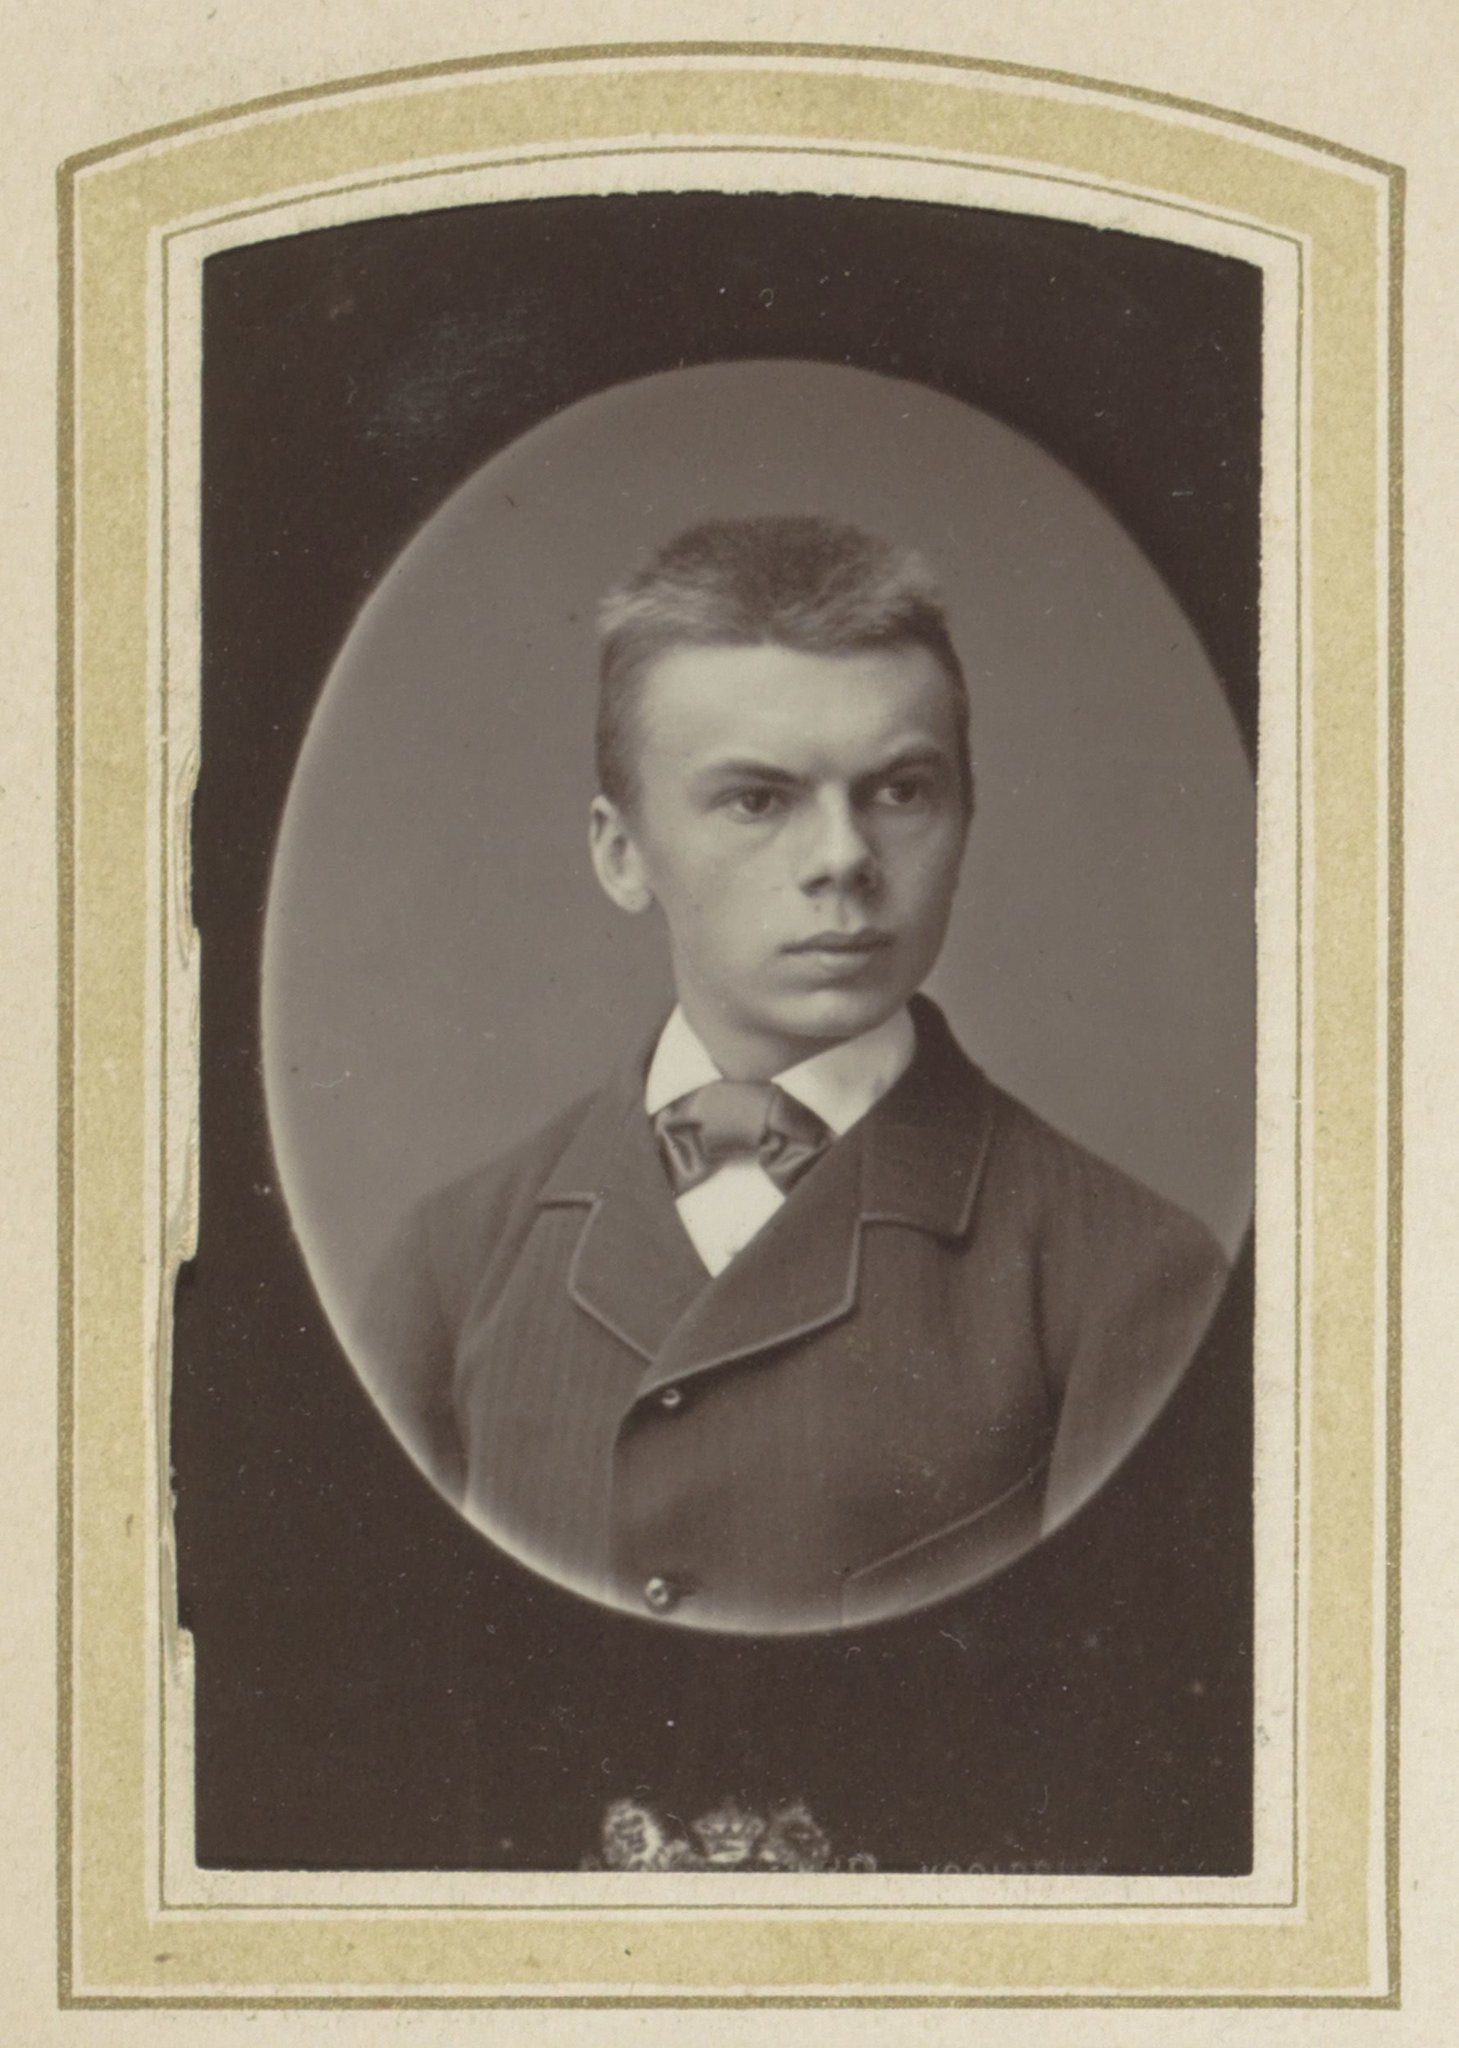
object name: carte de visite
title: Portret van een jongeman met een jas en een das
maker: albert greiner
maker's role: fotograaf, fotostudio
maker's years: 1833-1890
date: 1882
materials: cardboard, paper, photographic support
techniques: carbon print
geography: amsterdam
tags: historical persons, neck-gear ~ clothing, clothing for the upper part of the body, hairdress, amsterdam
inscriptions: address: ‘Amsterdam’, address: ‘Nieuwendijk L. 89 Amsterdam’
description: Onderdeel van Fotoalbum van een Nederlandse familie met 168 cartes-de-visite en kabinetfoto's.